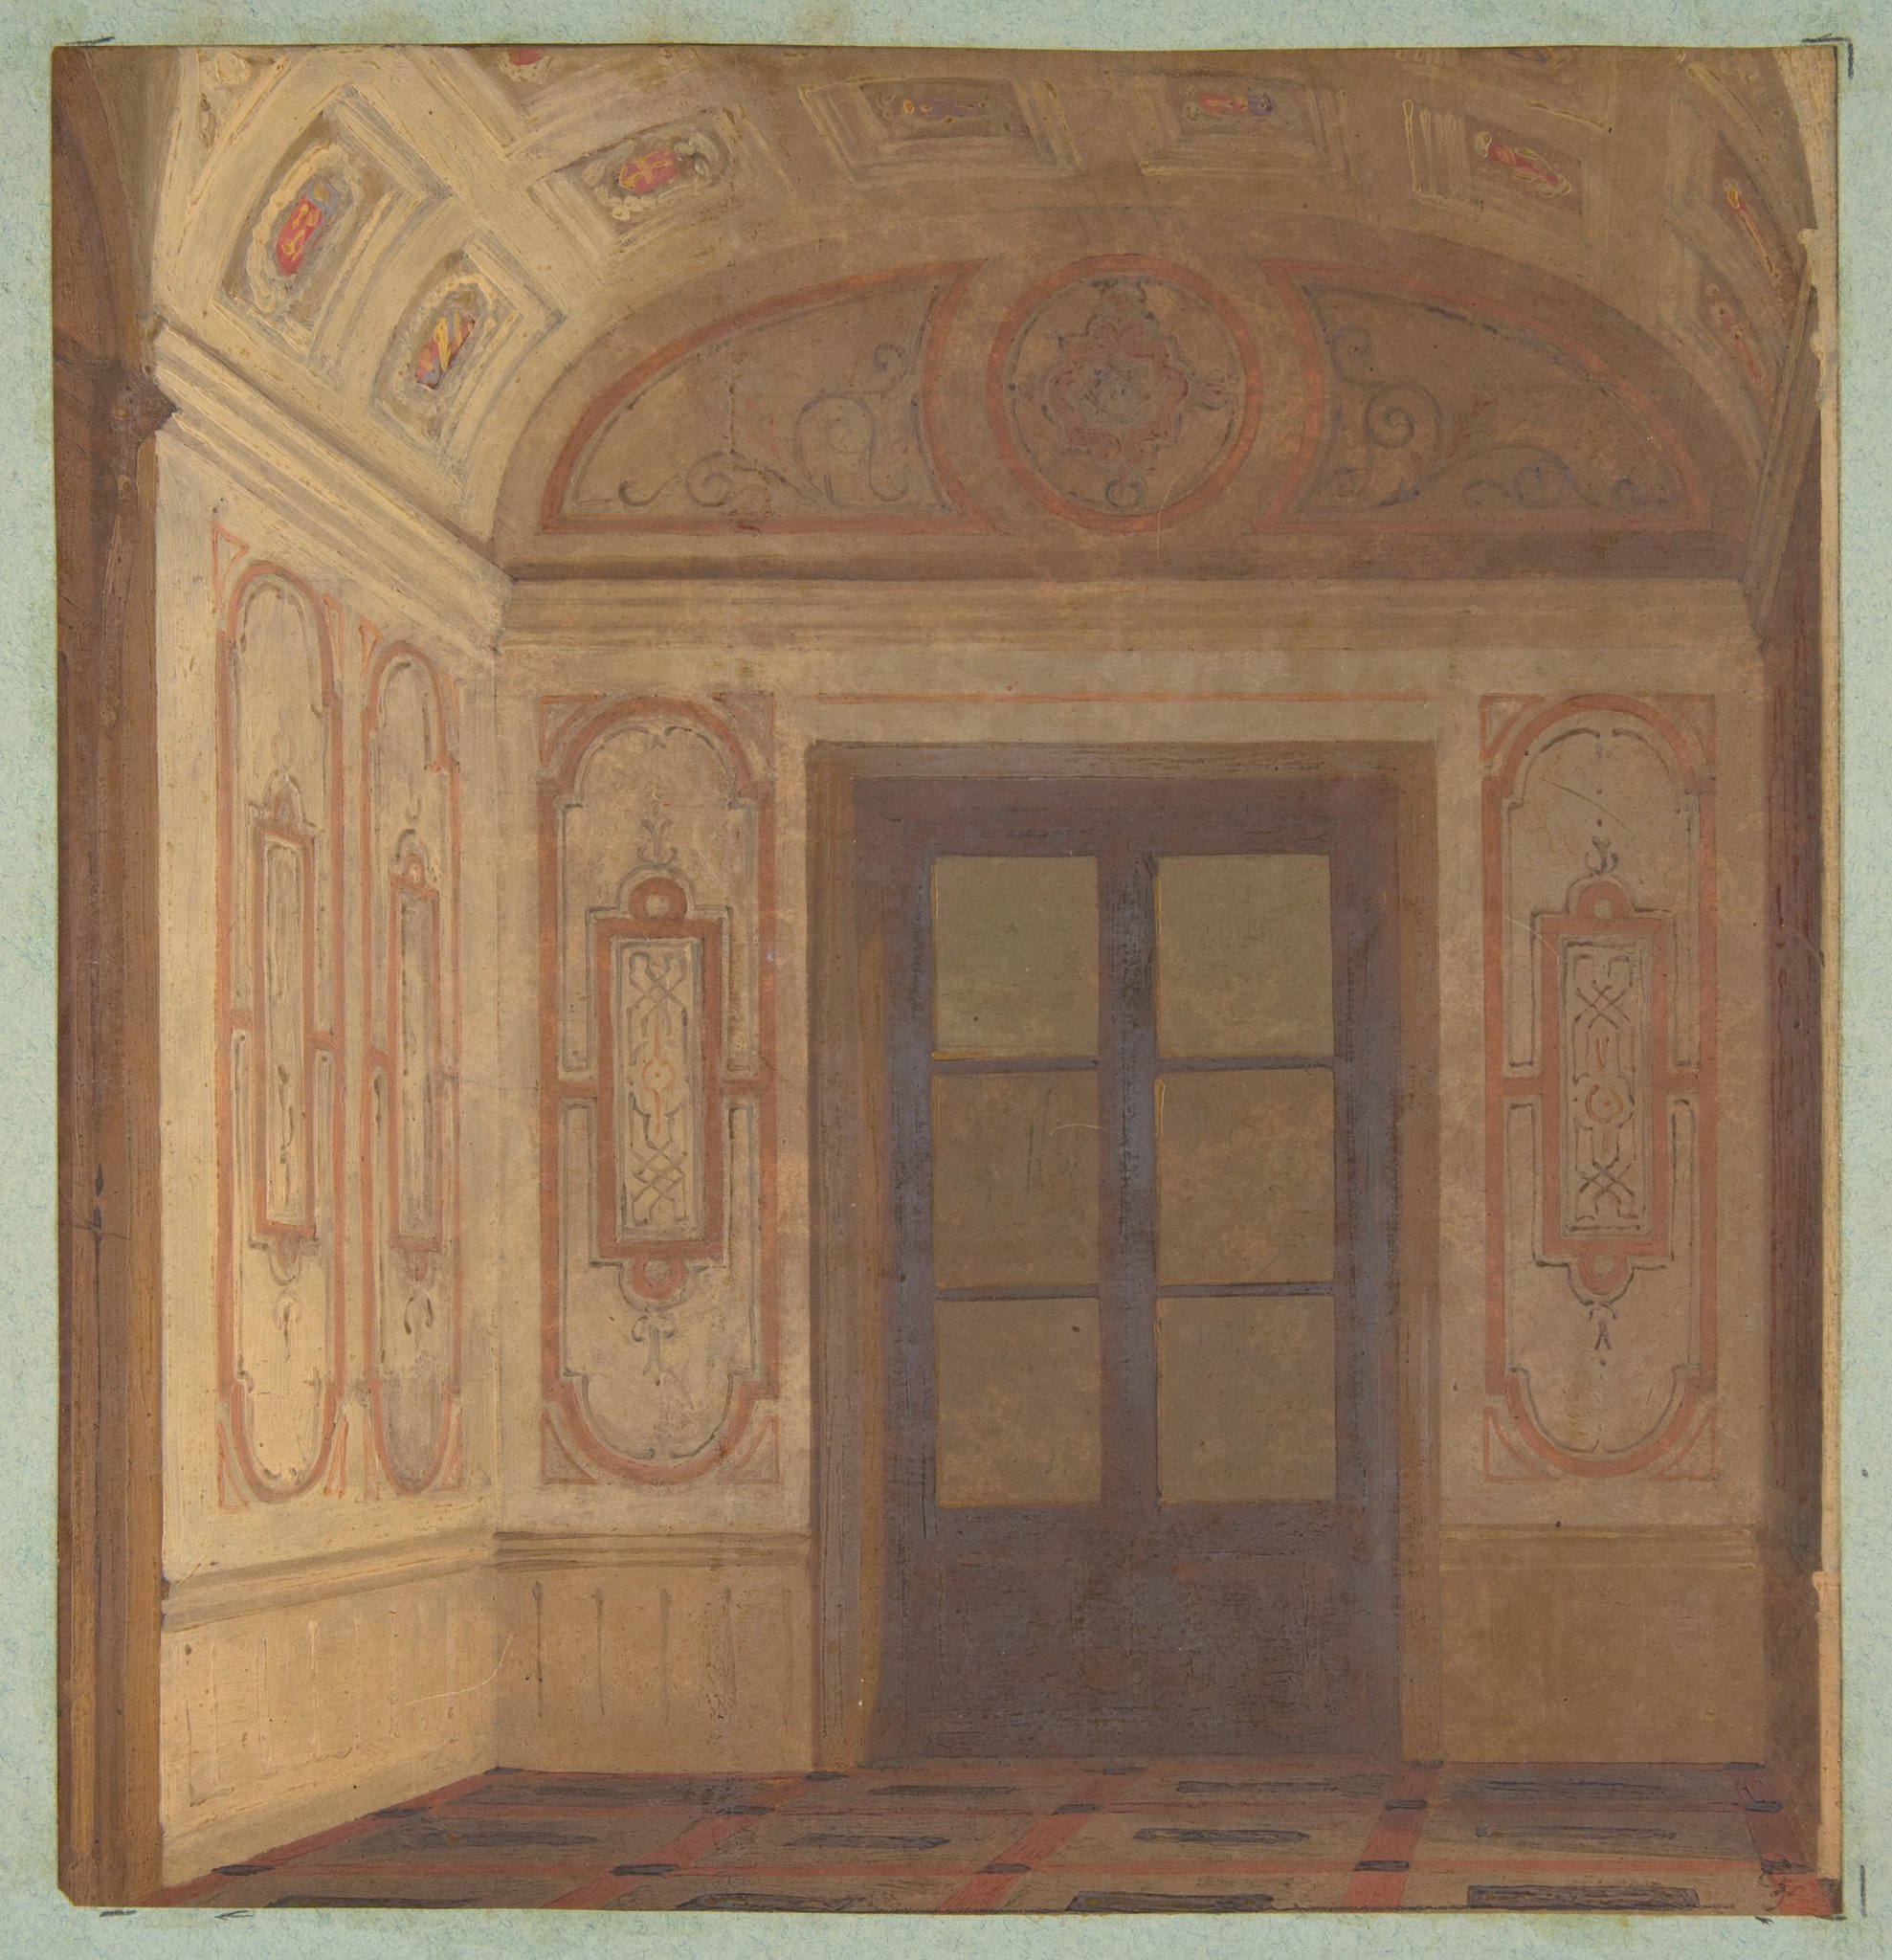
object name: drawing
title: Design for the Vestibule of the Chateau de Lude (Sarthe)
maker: jules-edmond-charles lachaise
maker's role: artist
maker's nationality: french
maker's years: 1897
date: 1851-1900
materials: oil, paper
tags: doors